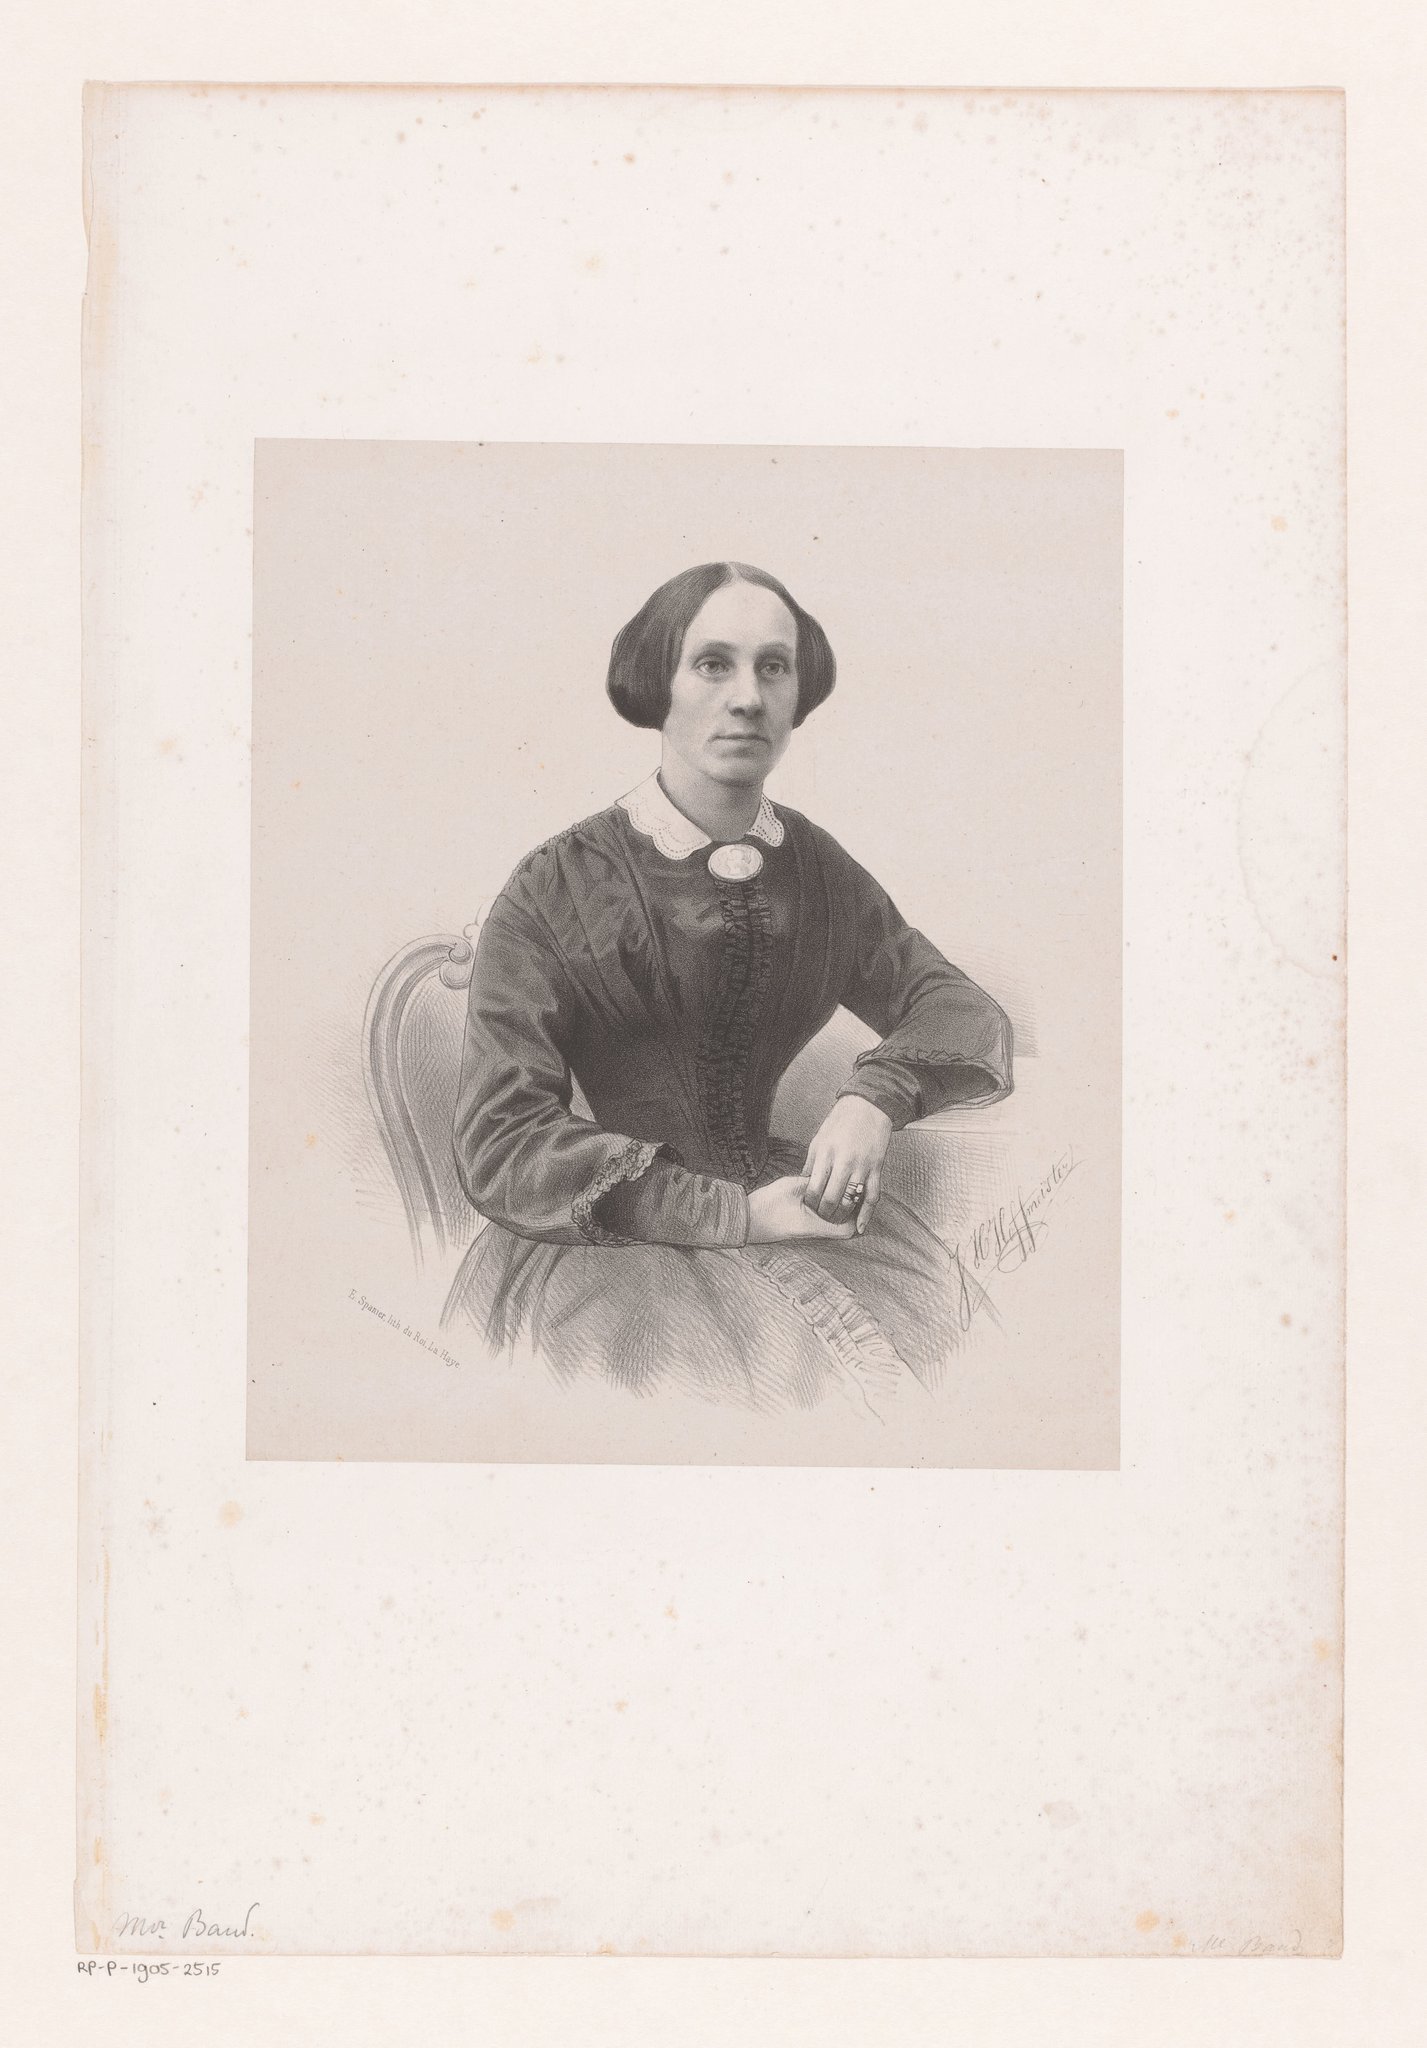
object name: print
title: Portret van mevrouw Baud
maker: johan hendrik hoffmeister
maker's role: print maker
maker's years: 1823-1904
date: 1851-1883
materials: paper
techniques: lithograph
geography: netherlands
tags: historical persons - bb - woman (+ (full) bust portrait)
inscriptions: collector's mark: Lugt 2228